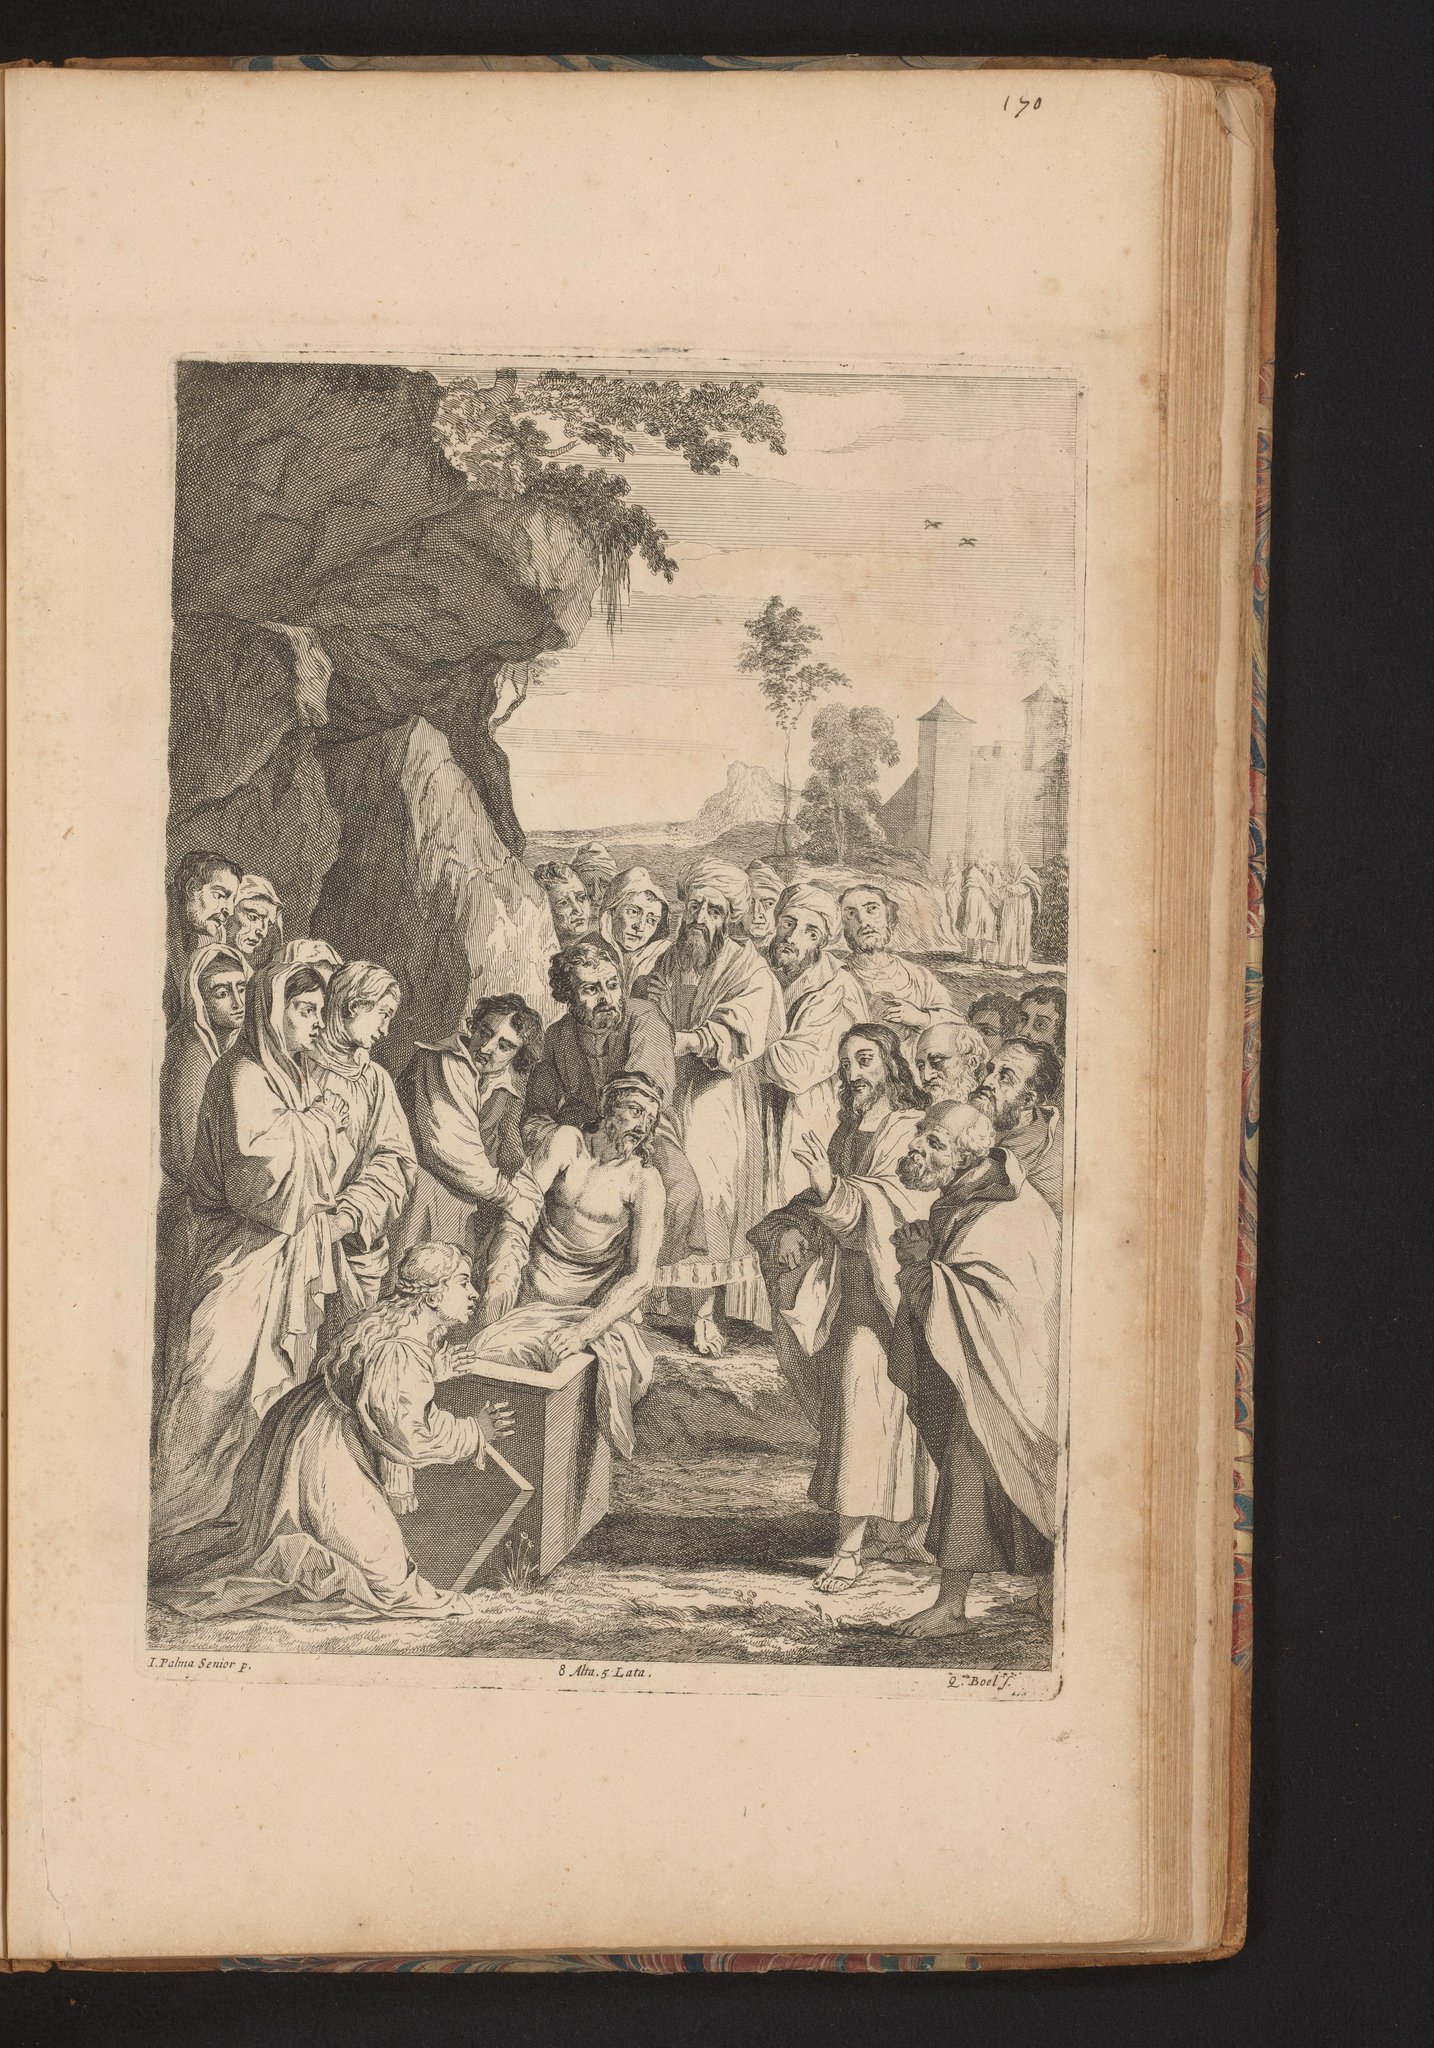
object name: album leaf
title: Opwekking van Lazarus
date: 1660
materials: paper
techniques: etching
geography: italy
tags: the raising of lazarus ('lazarus, come out')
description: David Teniers heeft waarschijnlijk van alle schilderijen uit de collectie van Leopold Willem van Oostenrijk een olieverfstudie op doek of paneel vervaardigd (zgn. pasticcio), die als voorbeeld voor de prentmakers diende. Het is niet altijd duidelijk of de pasticci door hem zijn gemaakt of door zijn atelier. Niet alle pasticci zijn overgeleverd.